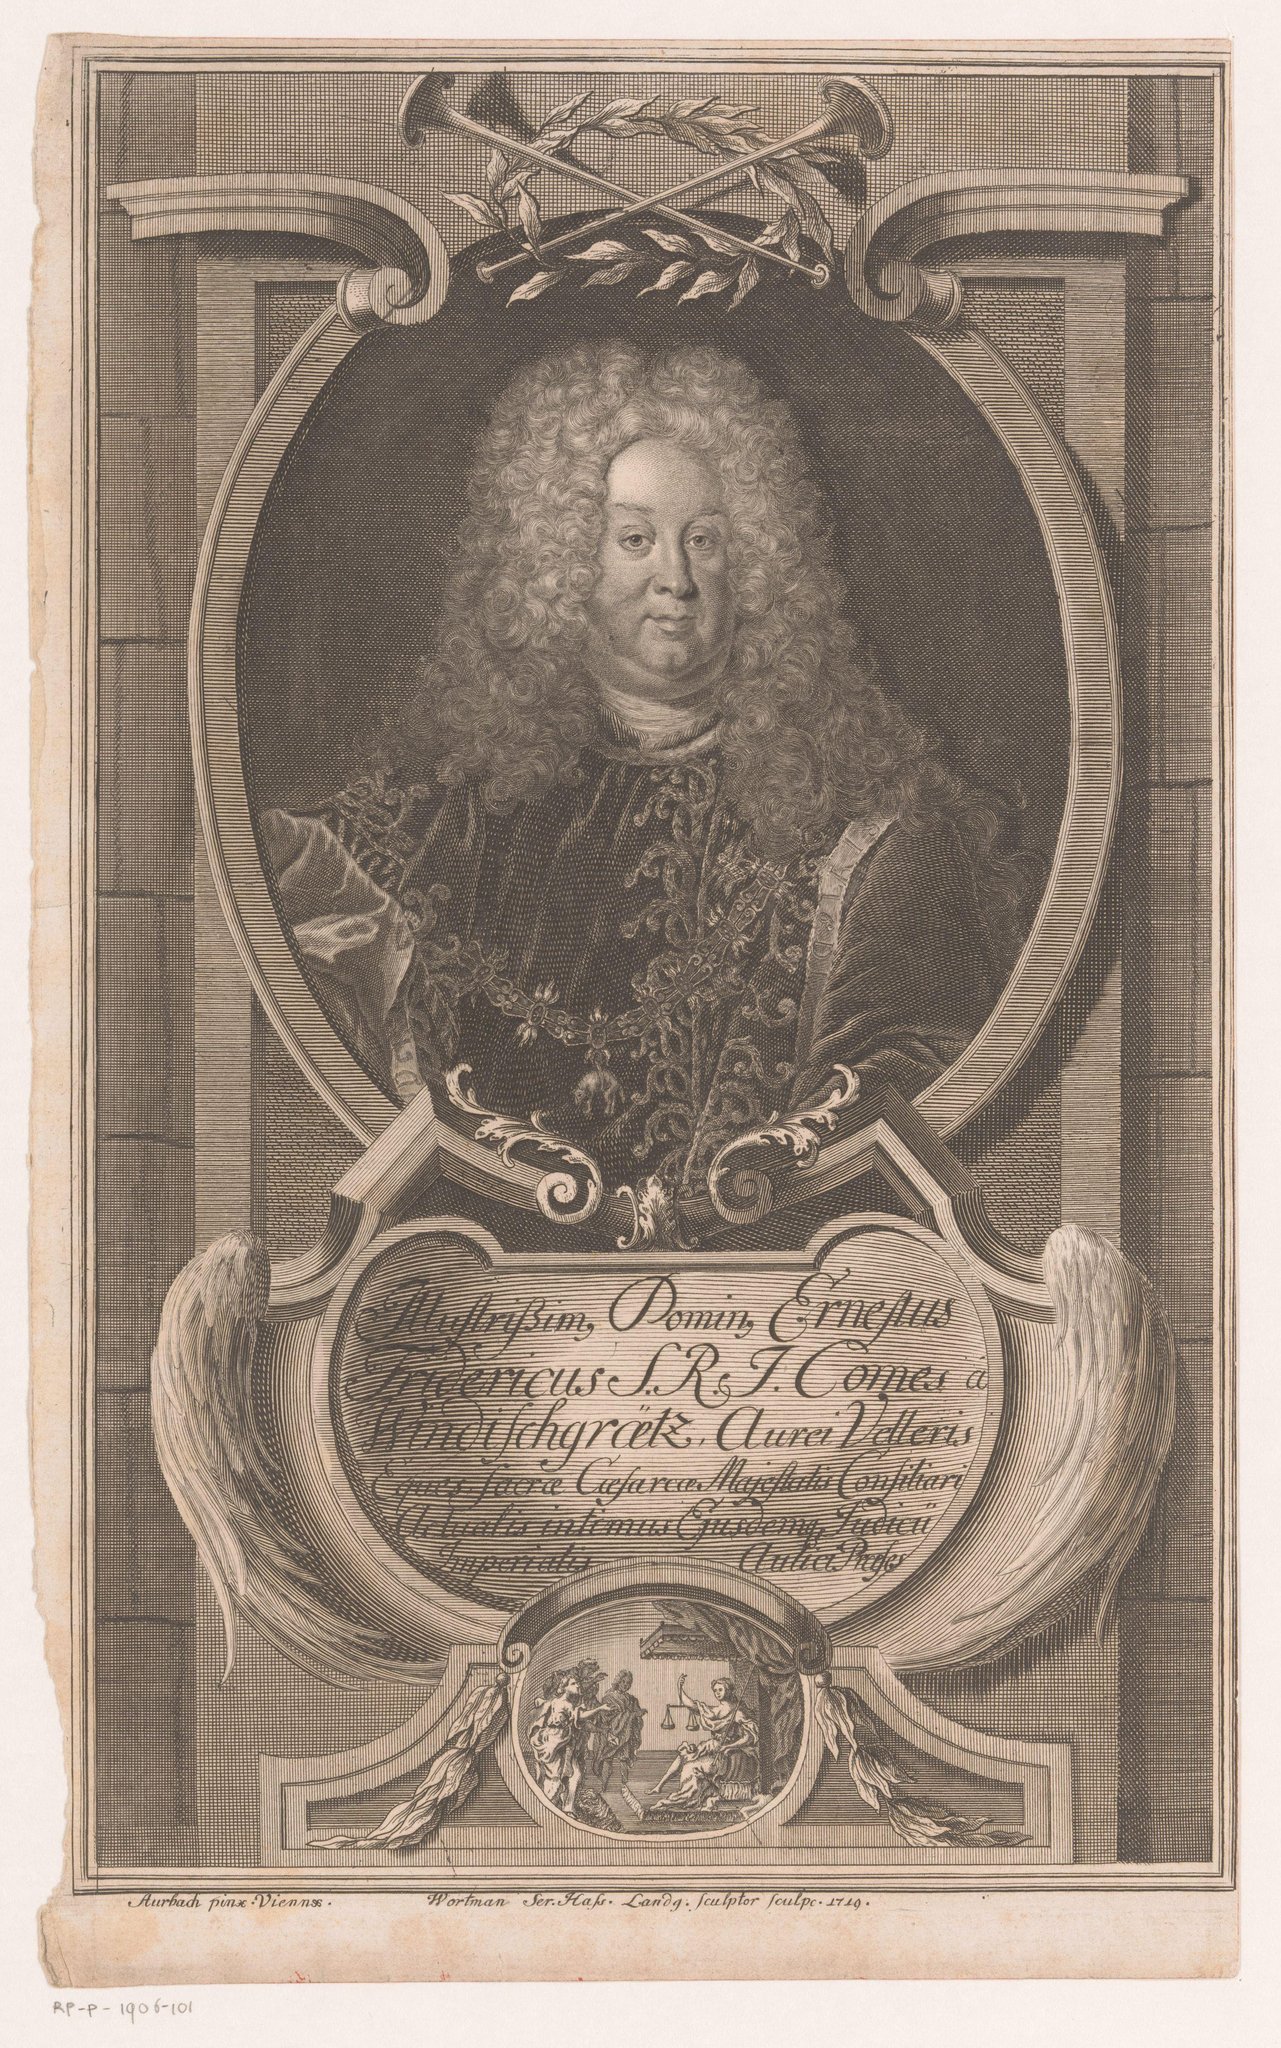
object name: print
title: Portret van Ernst Friedrich, Graf von Windisch-Graetz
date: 1719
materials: paper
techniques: engraving, etching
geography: germany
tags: vienna, austria, historical persons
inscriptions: collector's mark: Lugt 2228